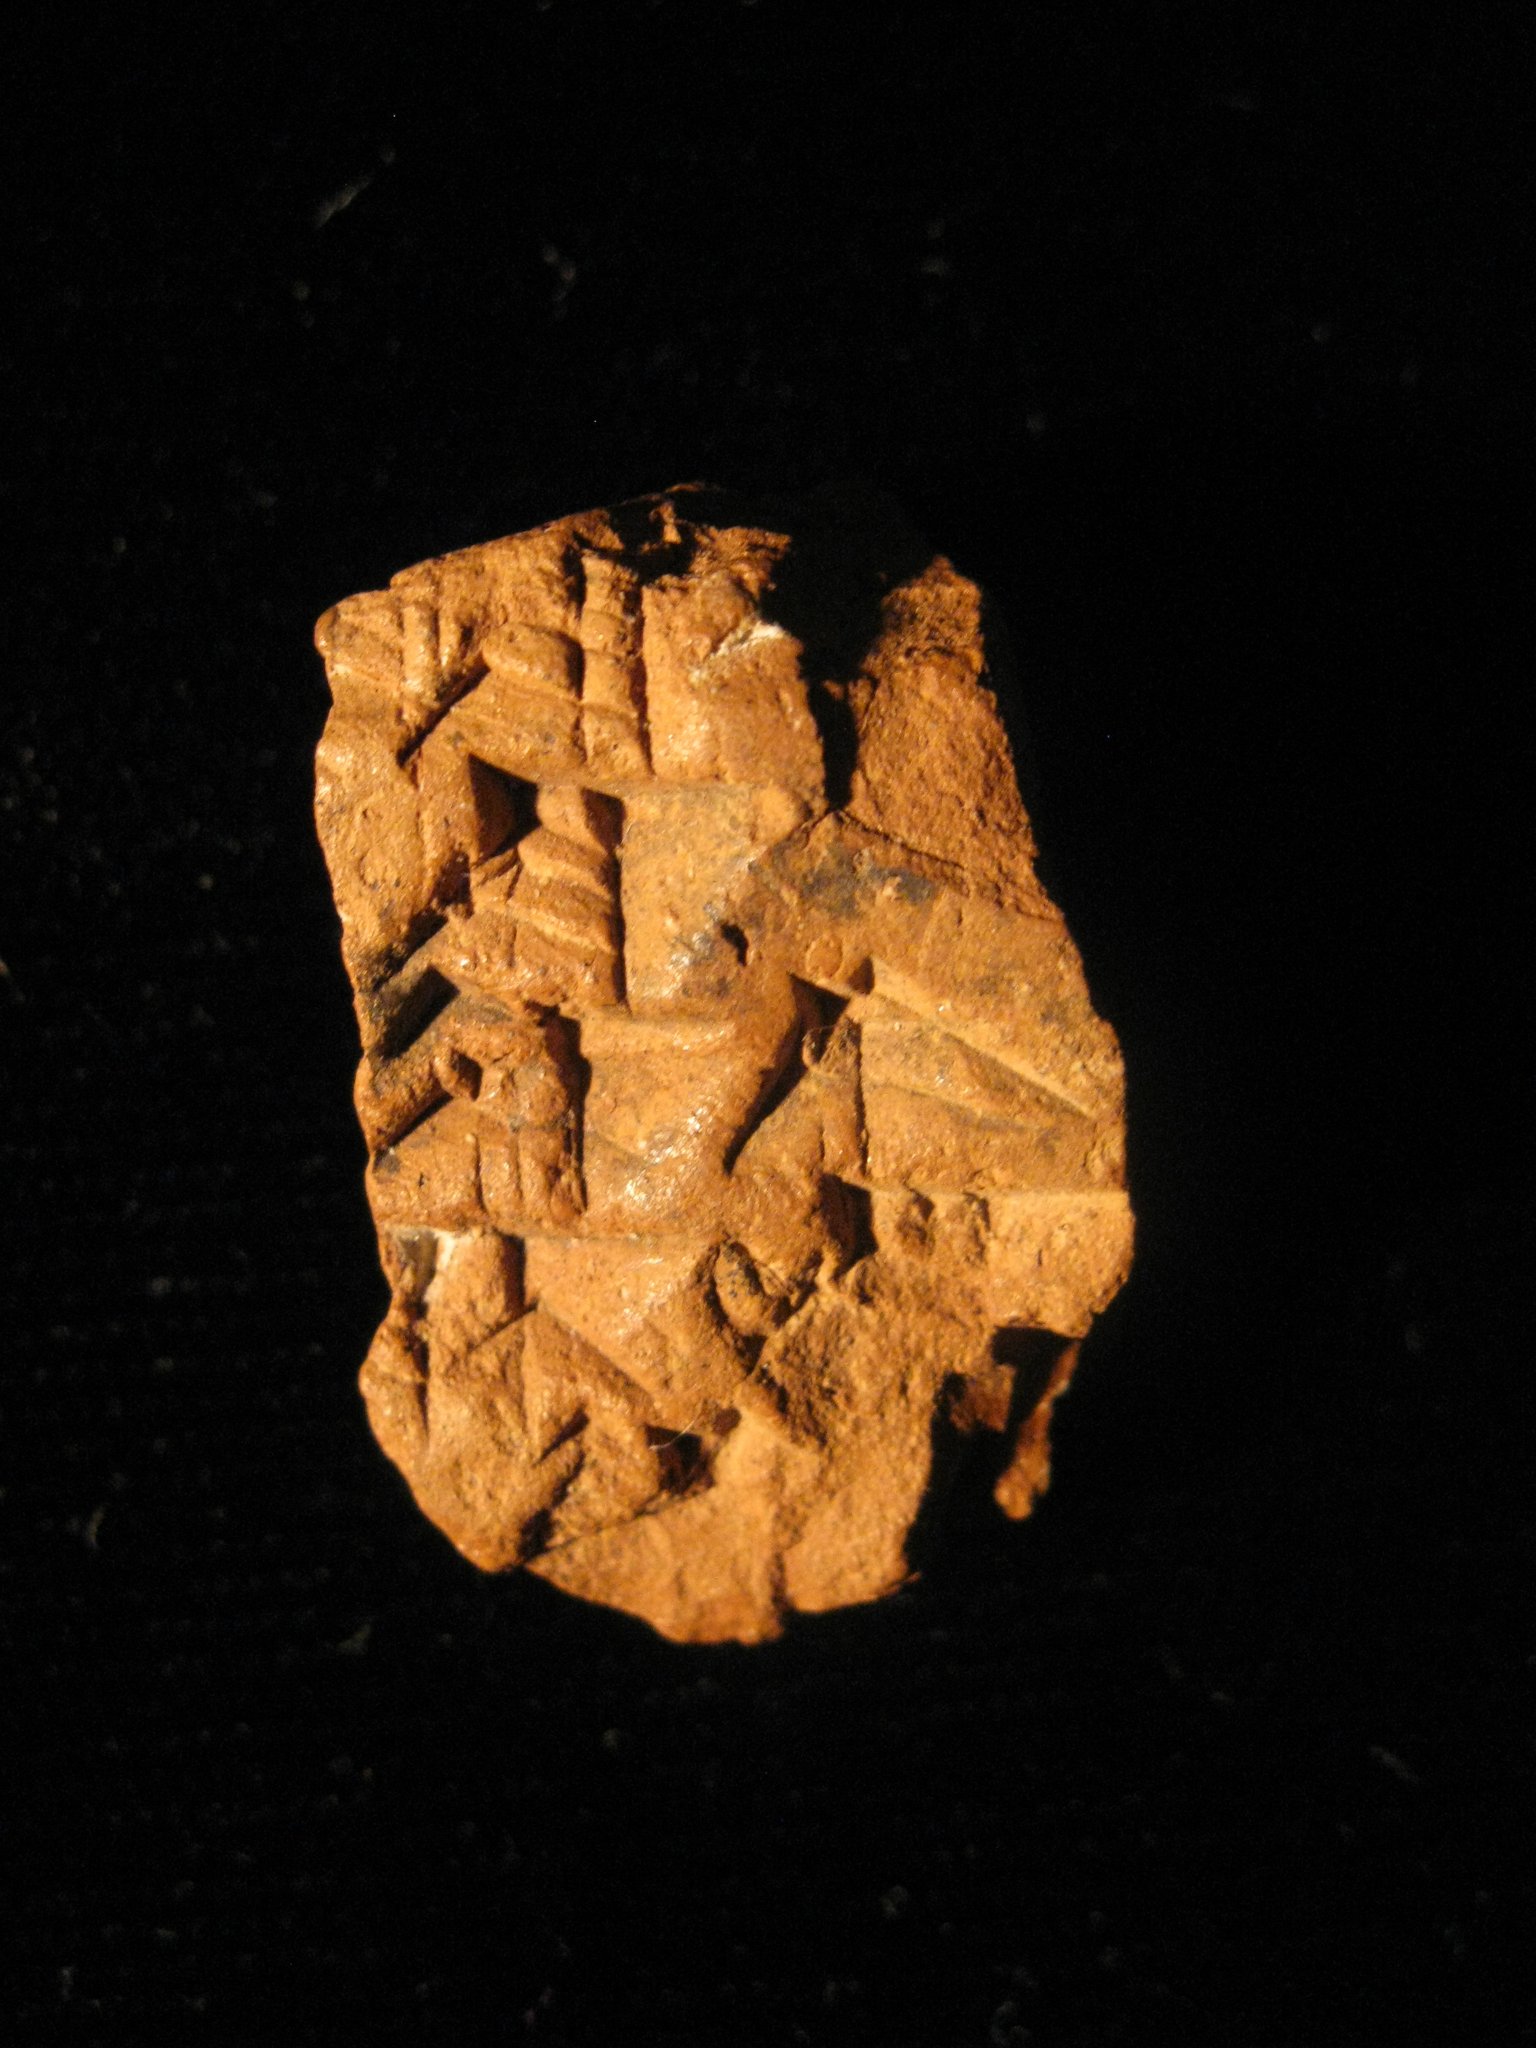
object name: cuneiform tablet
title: Cuneiform tablet: unidentified fragment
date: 333-1 BCE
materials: clay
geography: mesopotamia